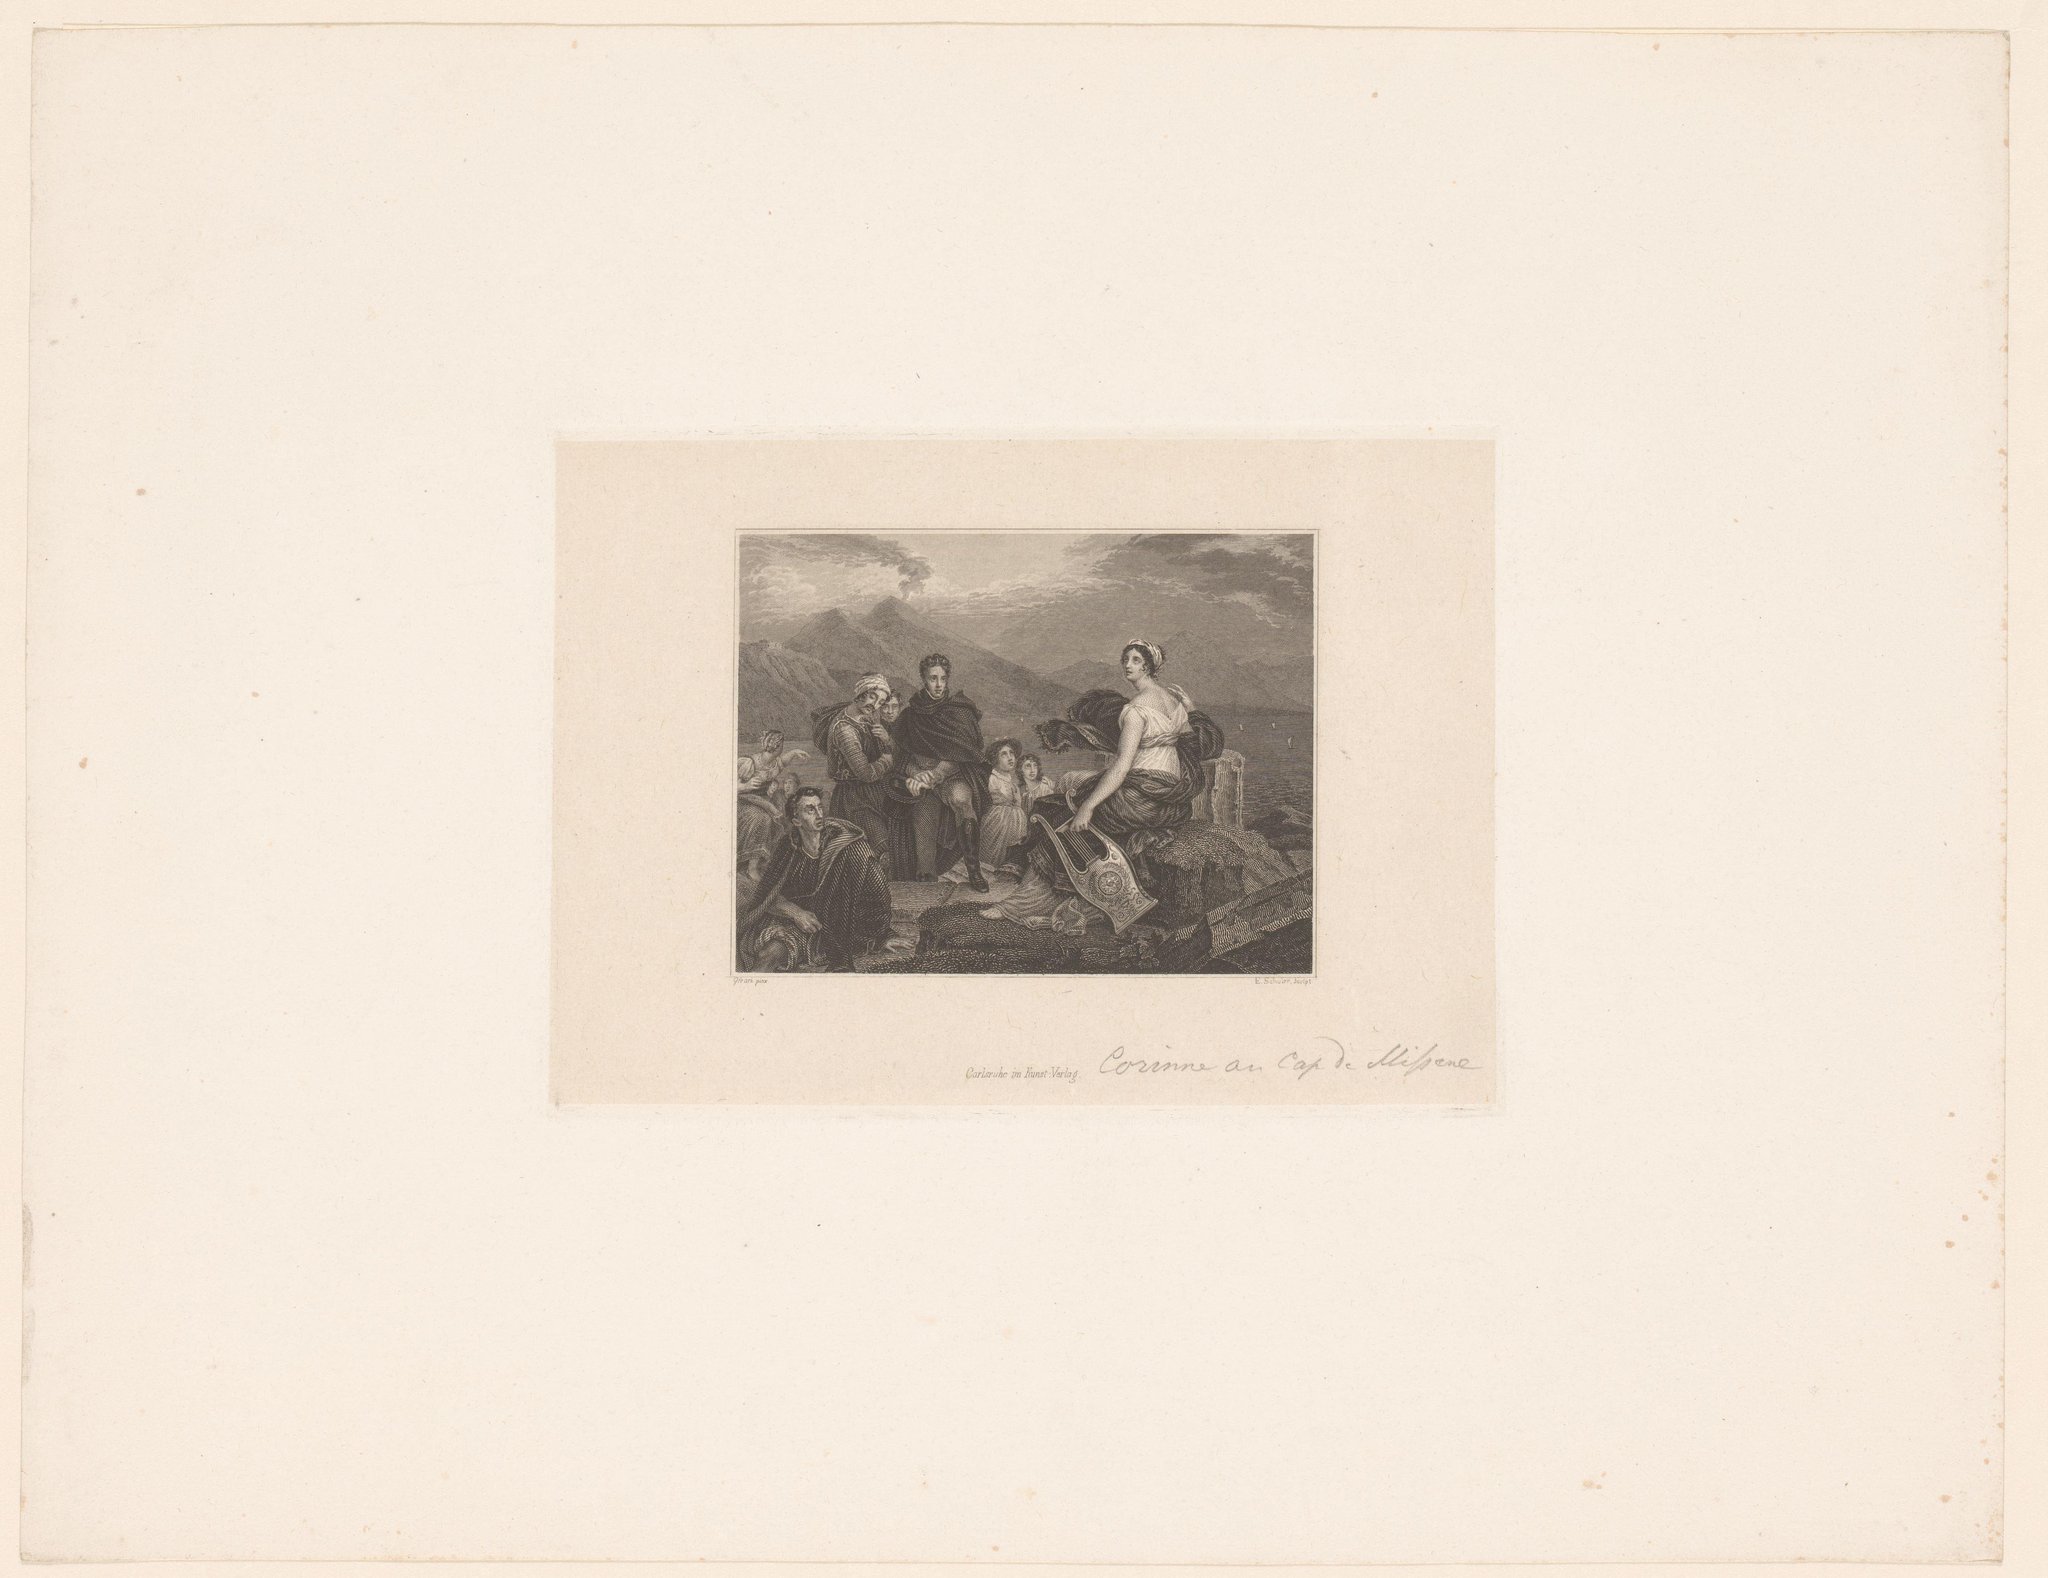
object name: print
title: Scène uit Corinne van Madame de Staël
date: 1816-1882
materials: paper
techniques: engraving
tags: literary characters and objects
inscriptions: collector's mark: Lugt 2228